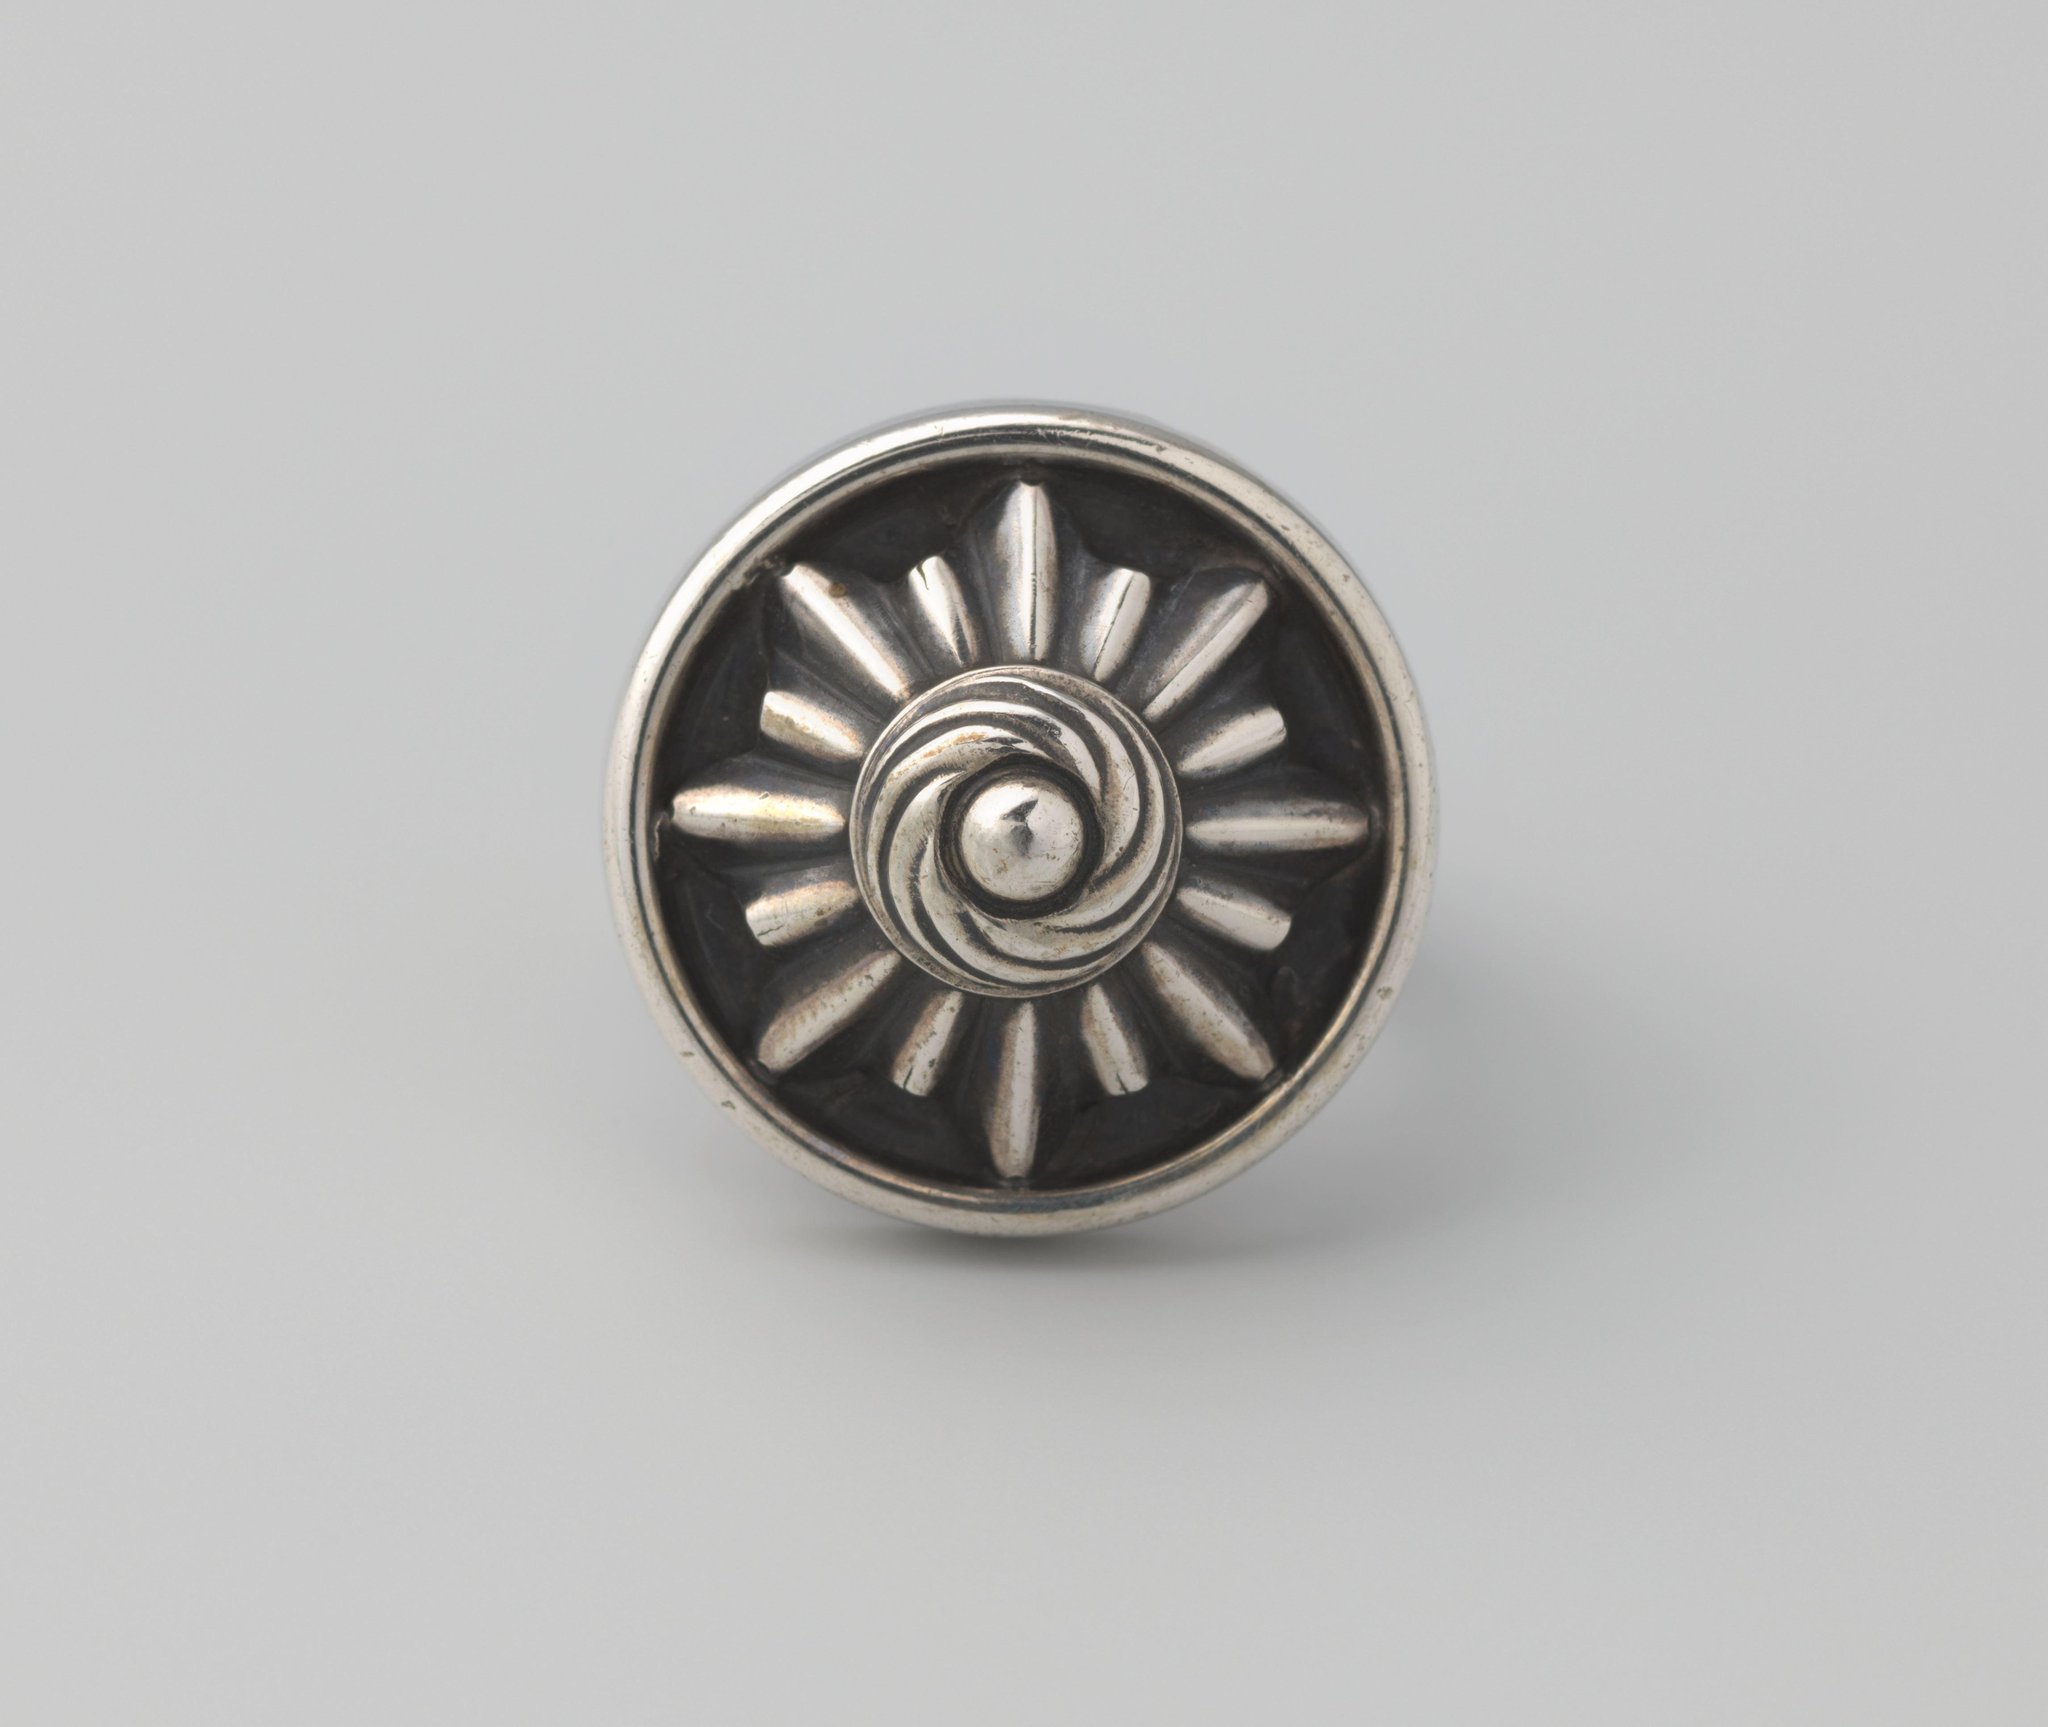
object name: ring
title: Tienerring met ronde knop met zwart veld waarin een gladde bloemvorm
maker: Anonymous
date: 1960-1970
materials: silver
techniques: blackening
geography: netherlands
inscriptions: maker's mark: ‘JdB’, alloy mark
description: Tienerring van zilver met ronde knop met zwart veld waarin een gladde bloemvorm.